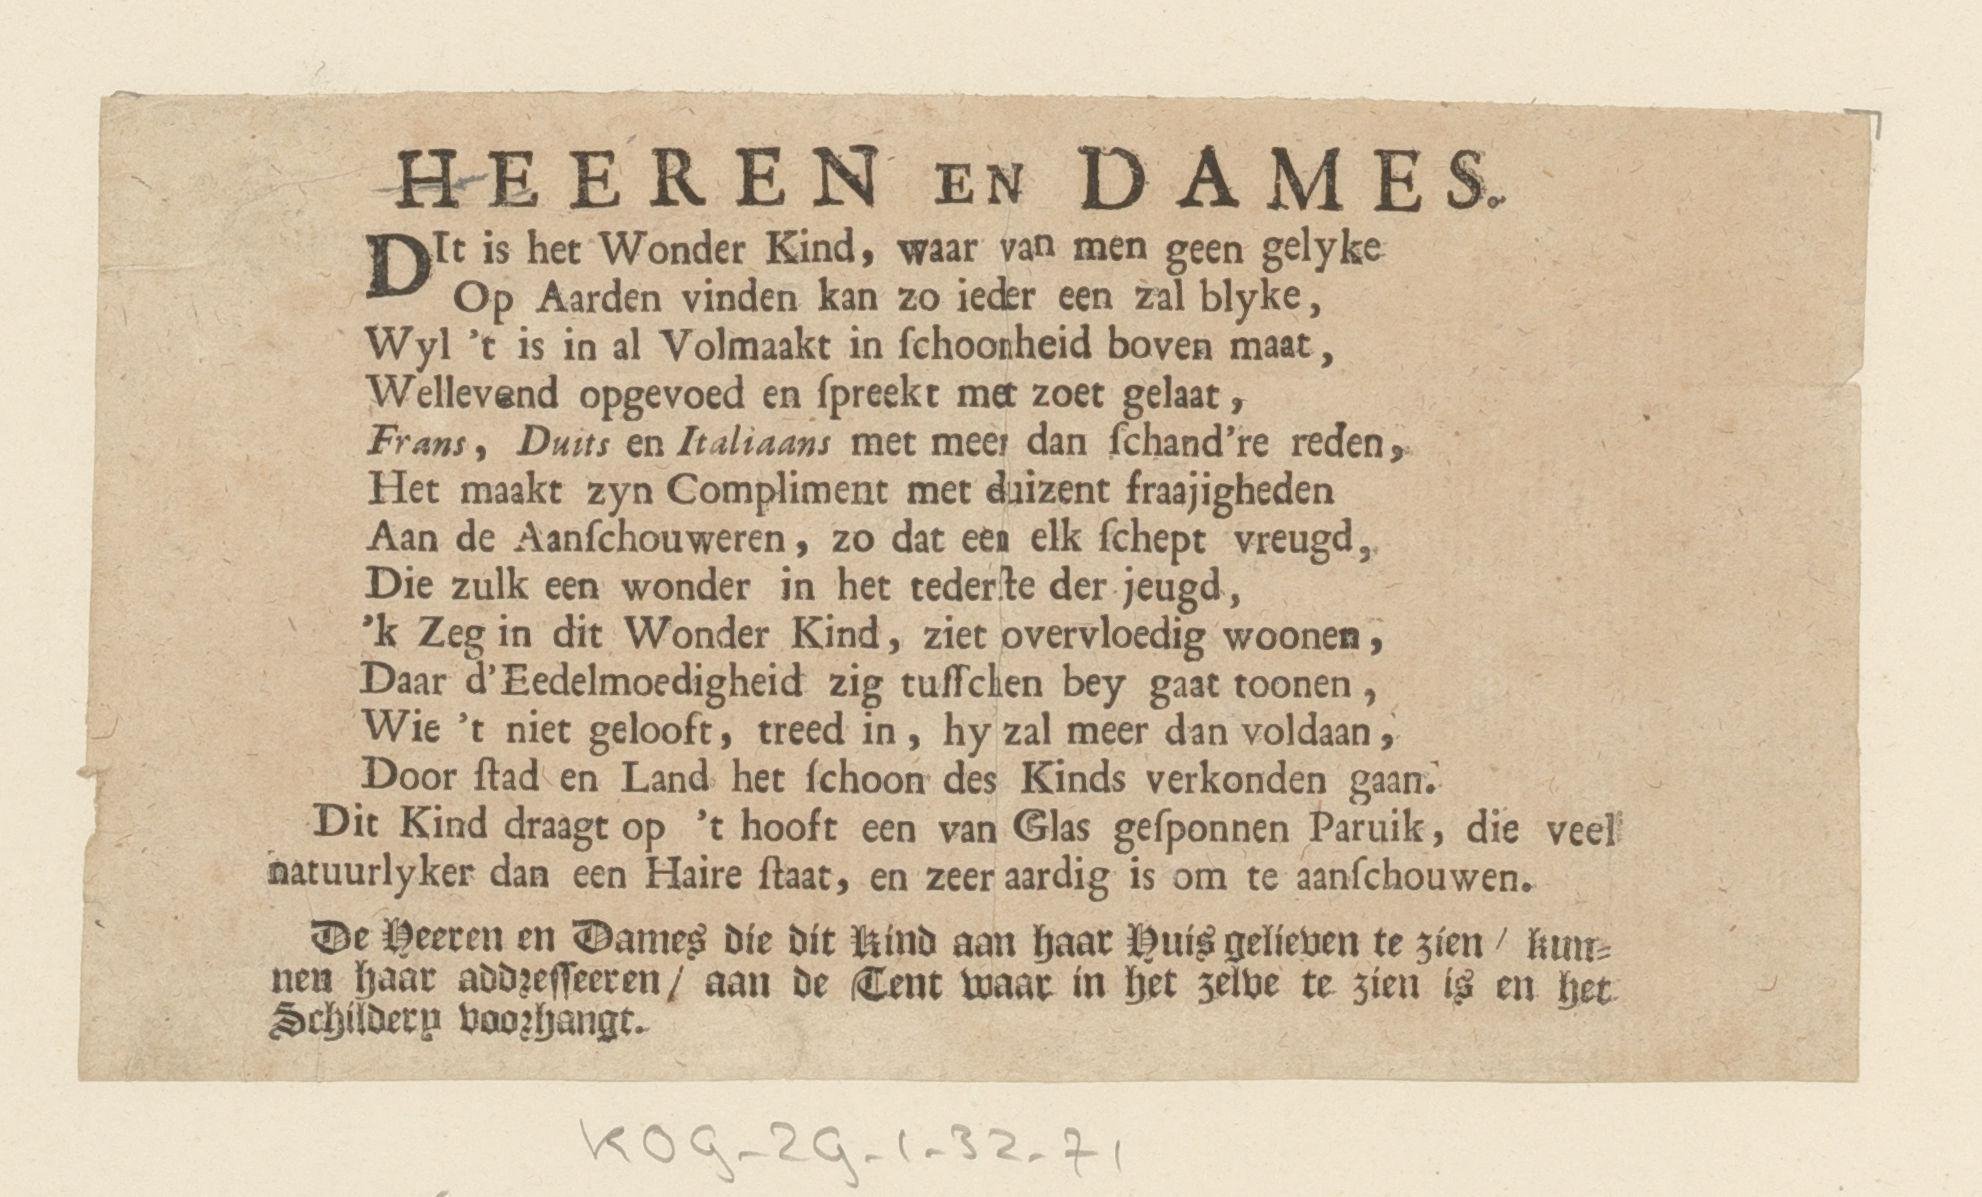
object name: reclamebiljet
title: Advertentie voor het Wonder-kind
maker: Anonymous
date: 1806-1815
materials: paper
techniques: letterpress printing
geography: netherlands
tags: wig - aa - ~ women, pleasure fair and circus, human monstrosities ~ freak show, amsterdam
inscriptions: collector's mark, collector's mark: Lugt 1641